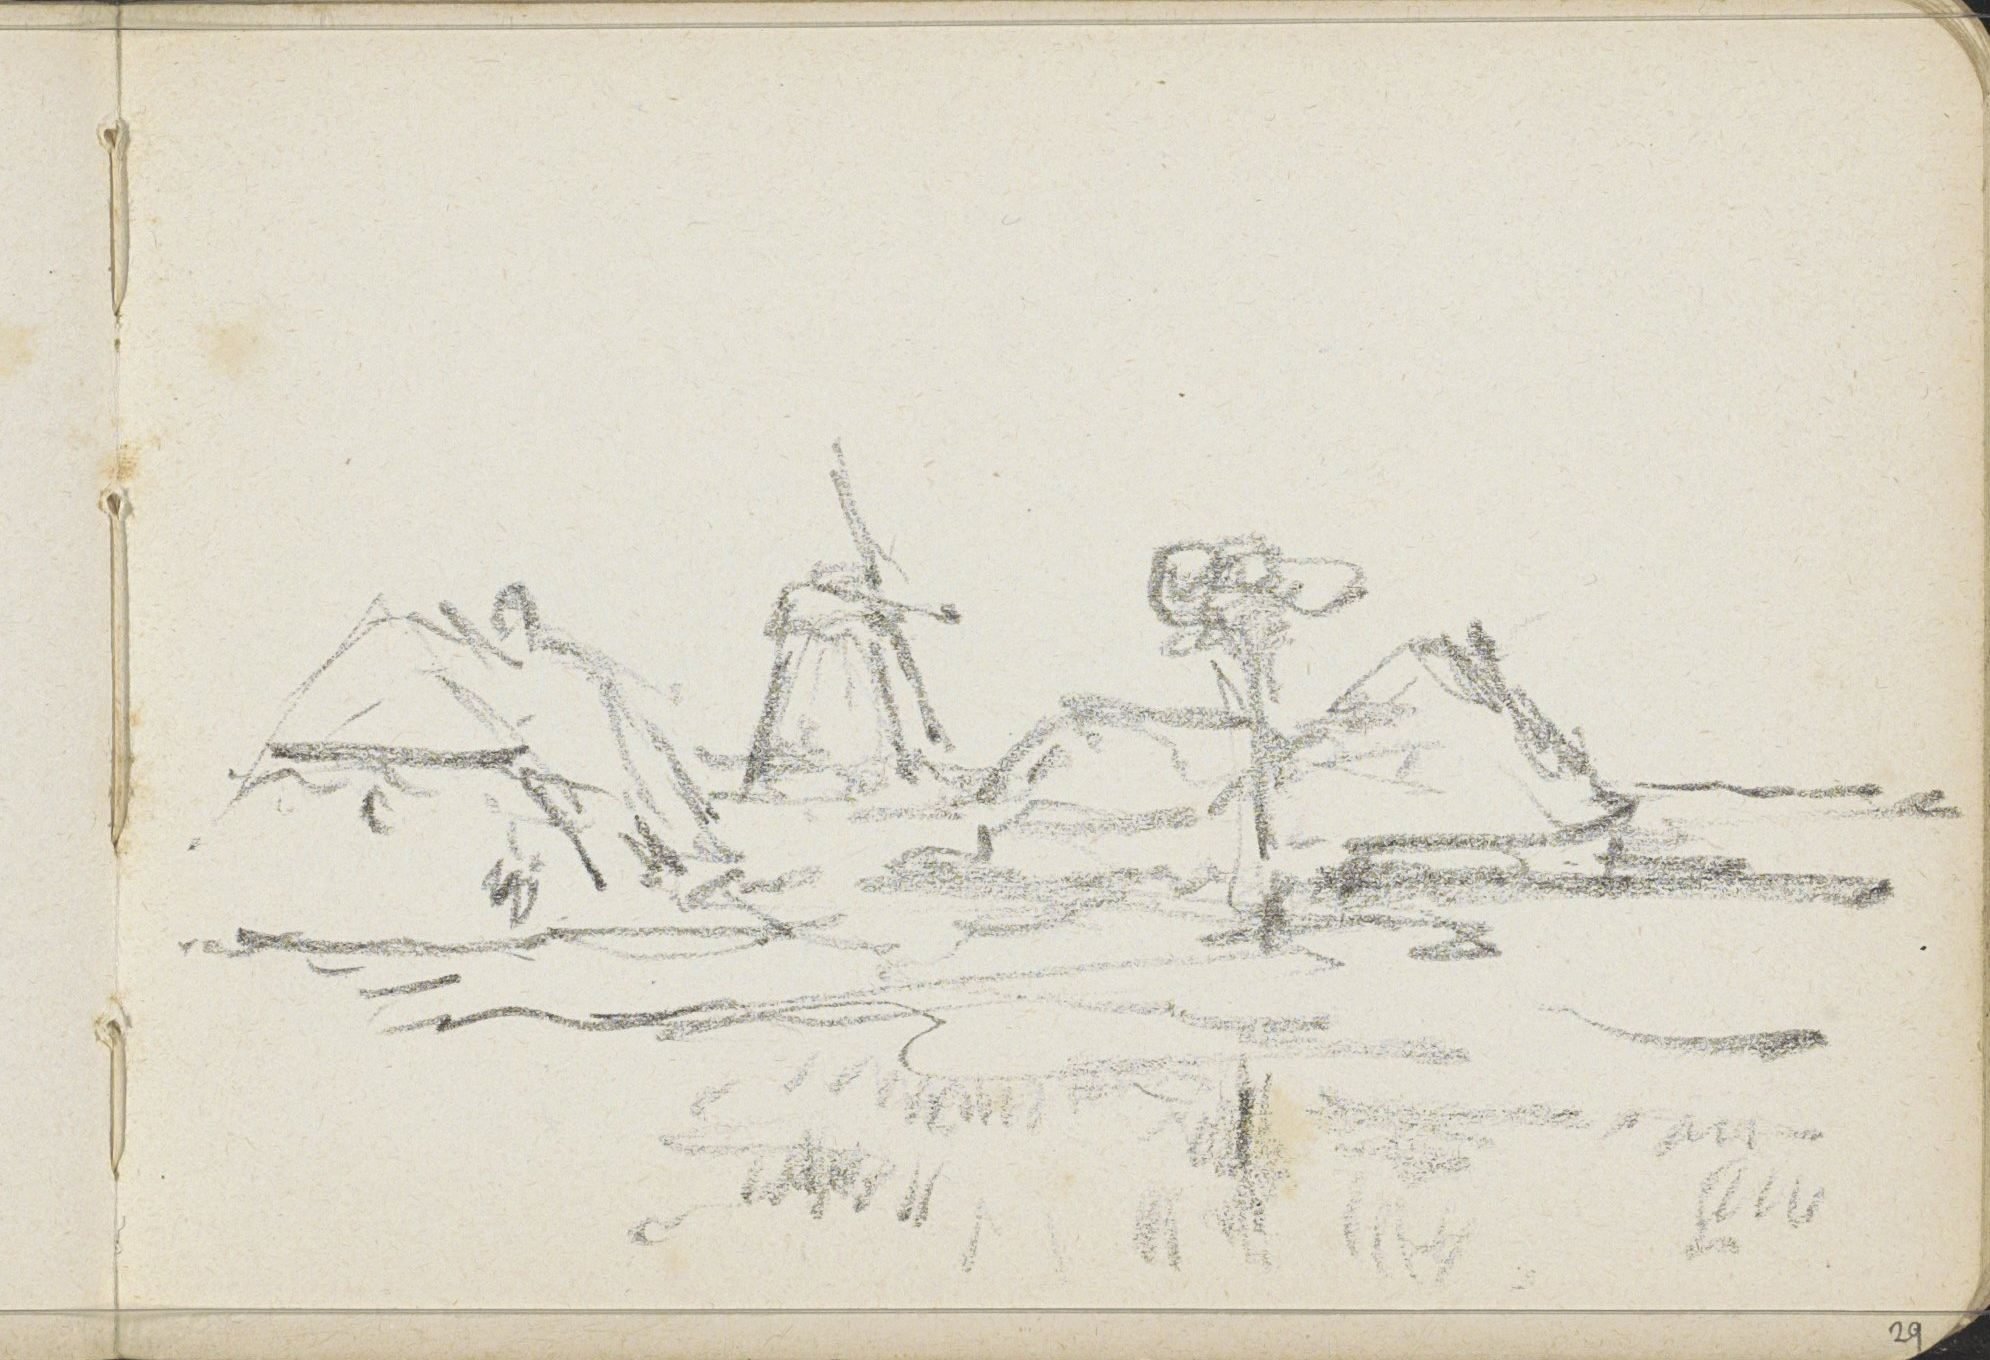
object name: sketchbook leaf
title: Landschap met boerderijen en een molen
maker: willem cornelis rip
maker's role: draughtsman, painter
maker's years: 1856-1922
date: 1866-1922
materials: chalk, paper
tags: windmill in landscape, farm (building)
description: Blad 29 recto uit een schetsboek met 44 bladen.